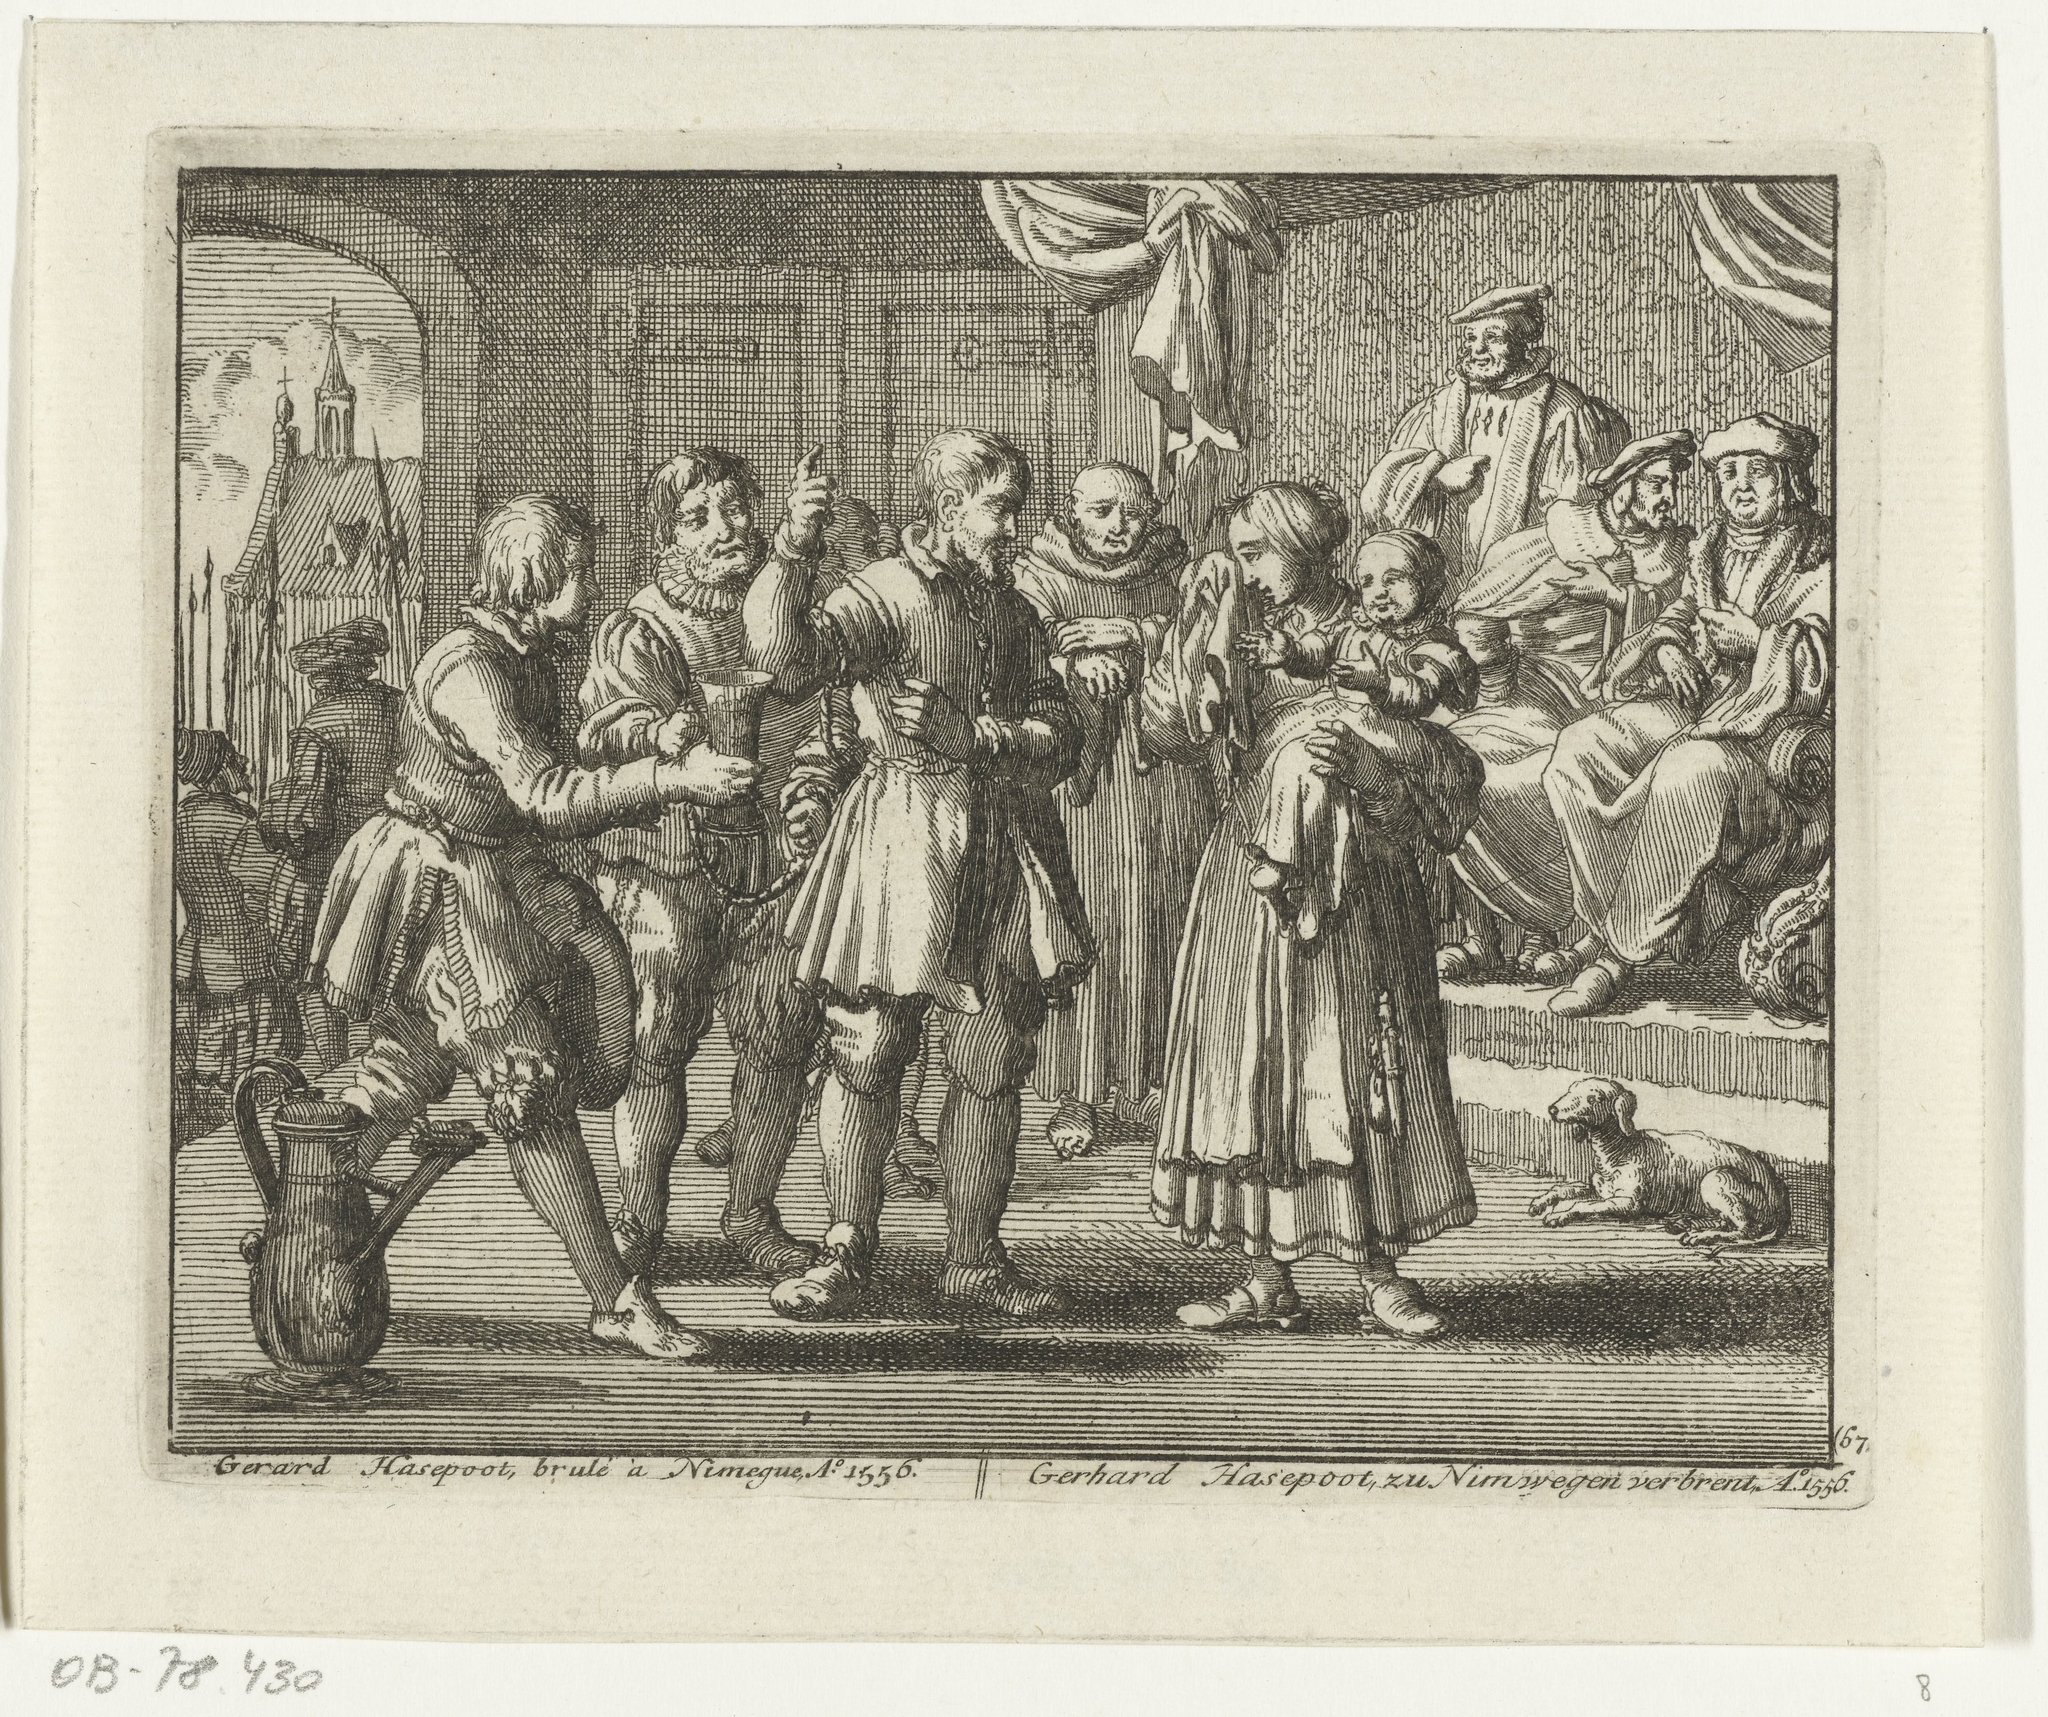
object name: history print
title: Gerrit Hasepoot te Nijmegen neemt afscheid van zijn gezin, 1556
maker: jan luyken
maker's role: draughtsman, print maker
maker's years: 1649-1712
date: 1683-1685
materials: paper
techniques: etching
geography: northern netherlands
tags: nijmegen, persecution of heretics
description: Deze prentn in de tweede staat gebruikt als illustratie voor: Theatre des martyrs, depuis la mort de J. Christ jusqu'à present (...). = Schau-buhne der Martyrer, P. van der Aa, Leiden ca. 1715, nr. 67. De prenten zijn oorspronkelijk vervaardigd voor en eerst gebruikt in: T.J. van Bragt, Het bloedig tooneel, of Martelaers spiegel der doops-gesinde of weereloose christenen, 1685.